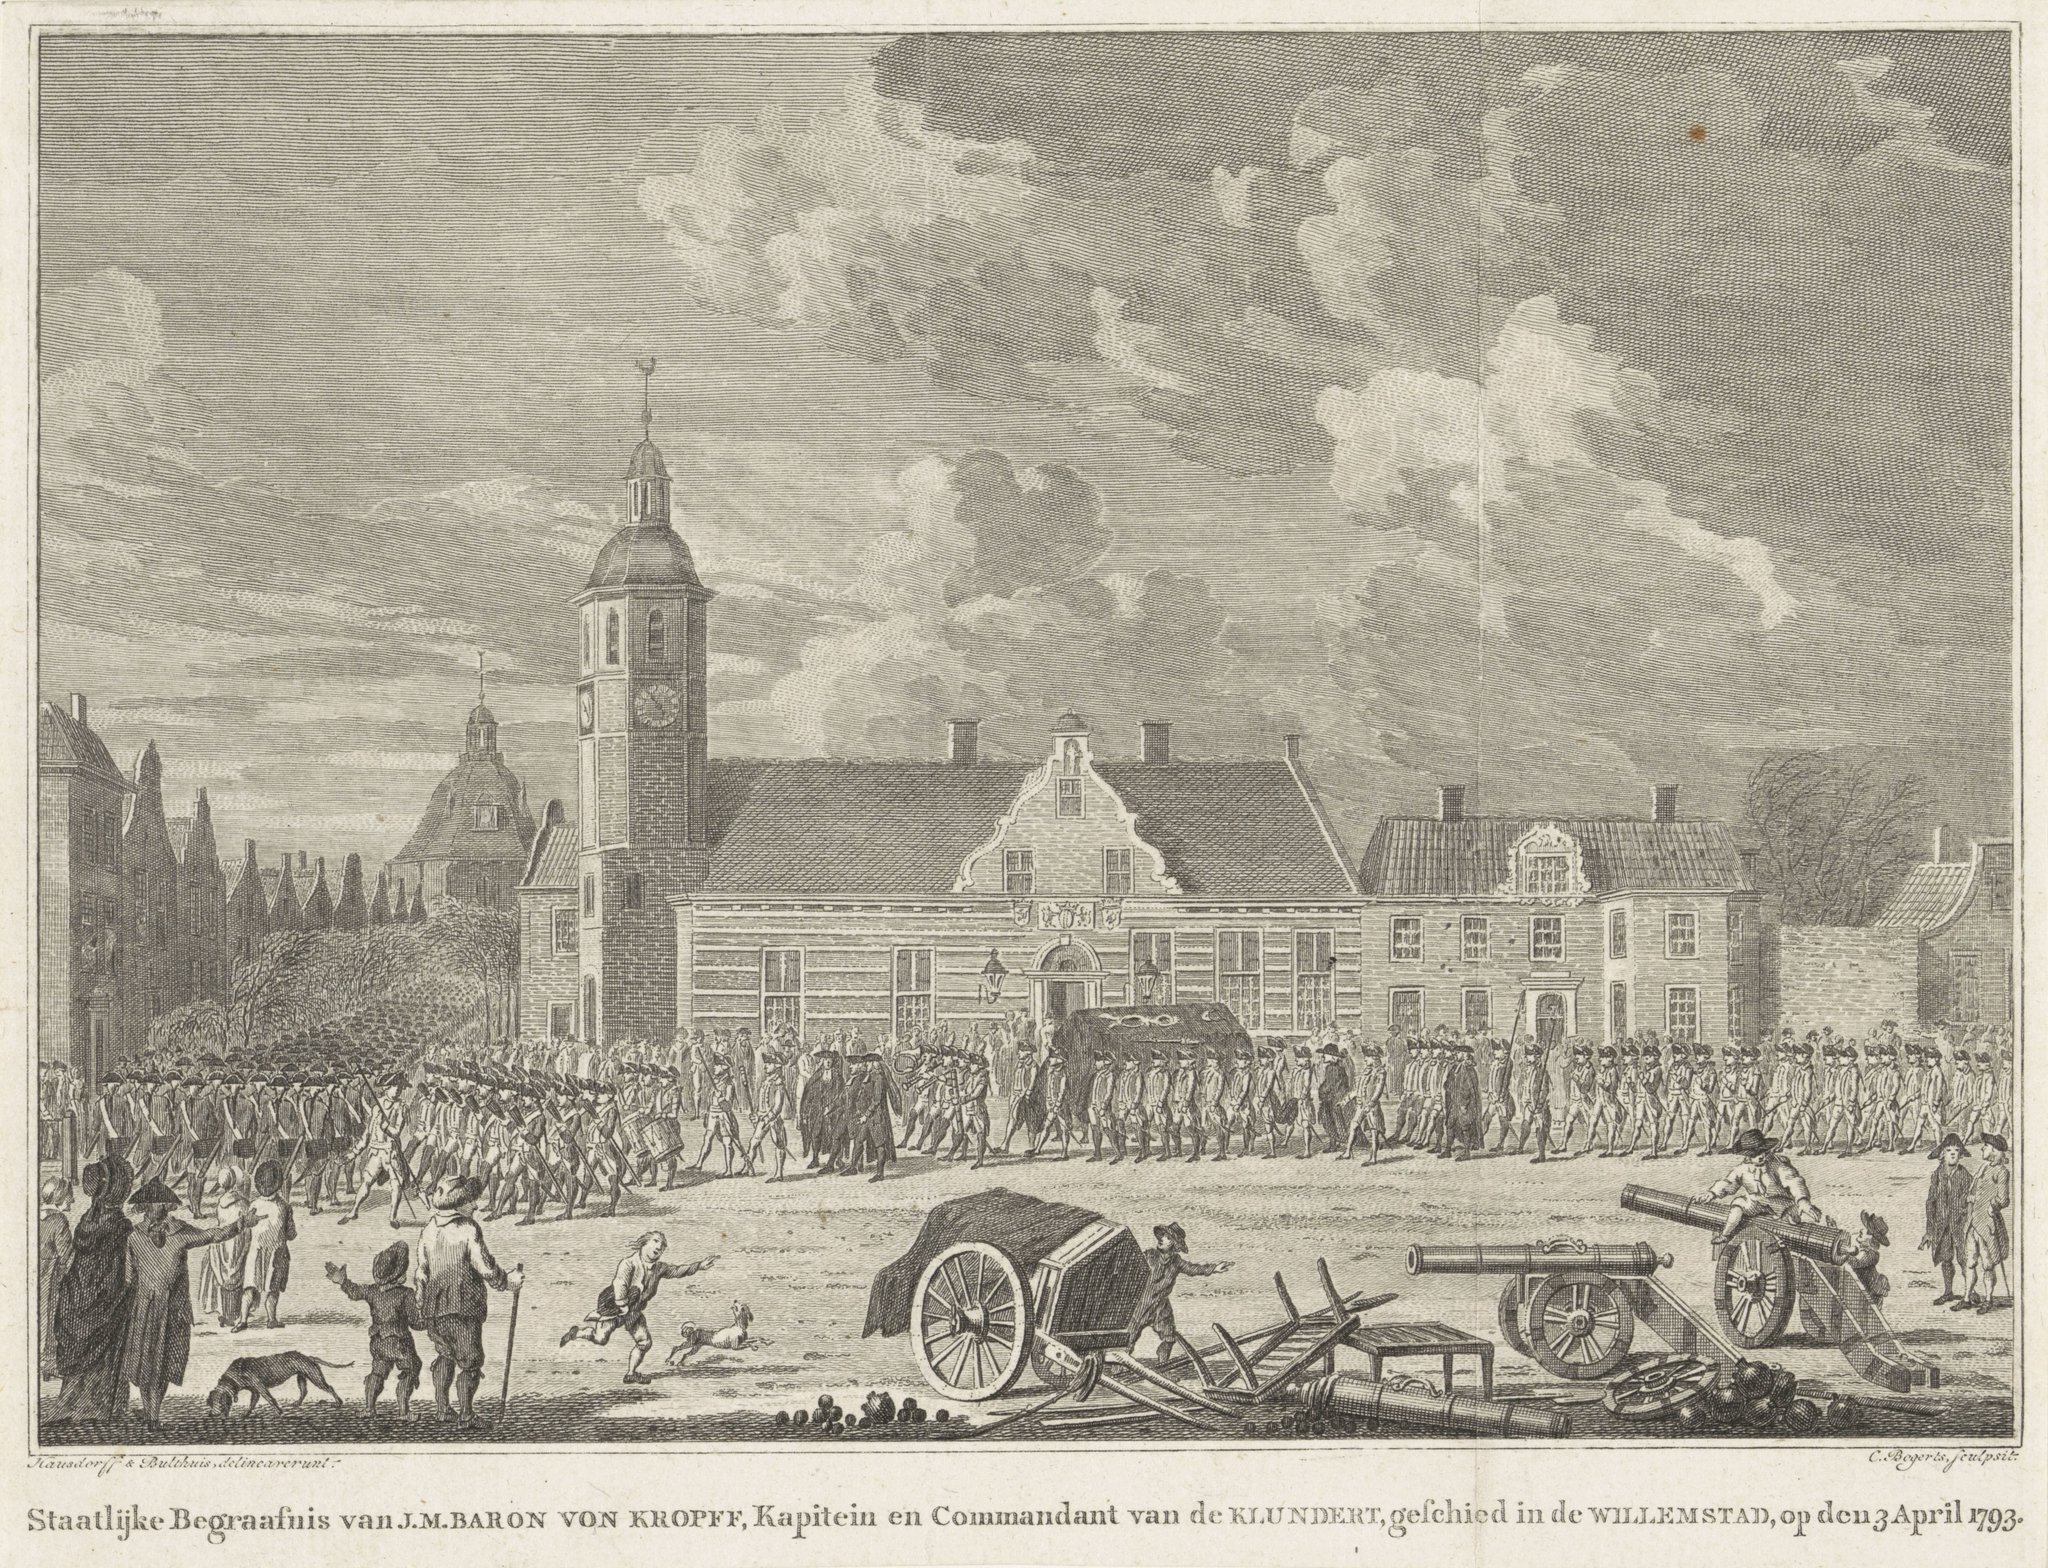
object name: print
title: Staatlijke Begraafnis van J.M. Baron von Kropff, Kapitein en Commandant van de Klundert, geschied in de Willemstad, op en 3 April 1793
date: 1793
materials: paper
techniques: engraving, etching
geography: northern netherlands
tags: public funeral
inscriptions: collector's mark: Lugt 2228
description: Begrafenisstoet voor Joachim Maurits baron van Kropff op de markt in Willemstad, 3 april 1793. De baron was commandant op het fort Klundert en sneuvelde tijdens de aanval van de Franse troepen.